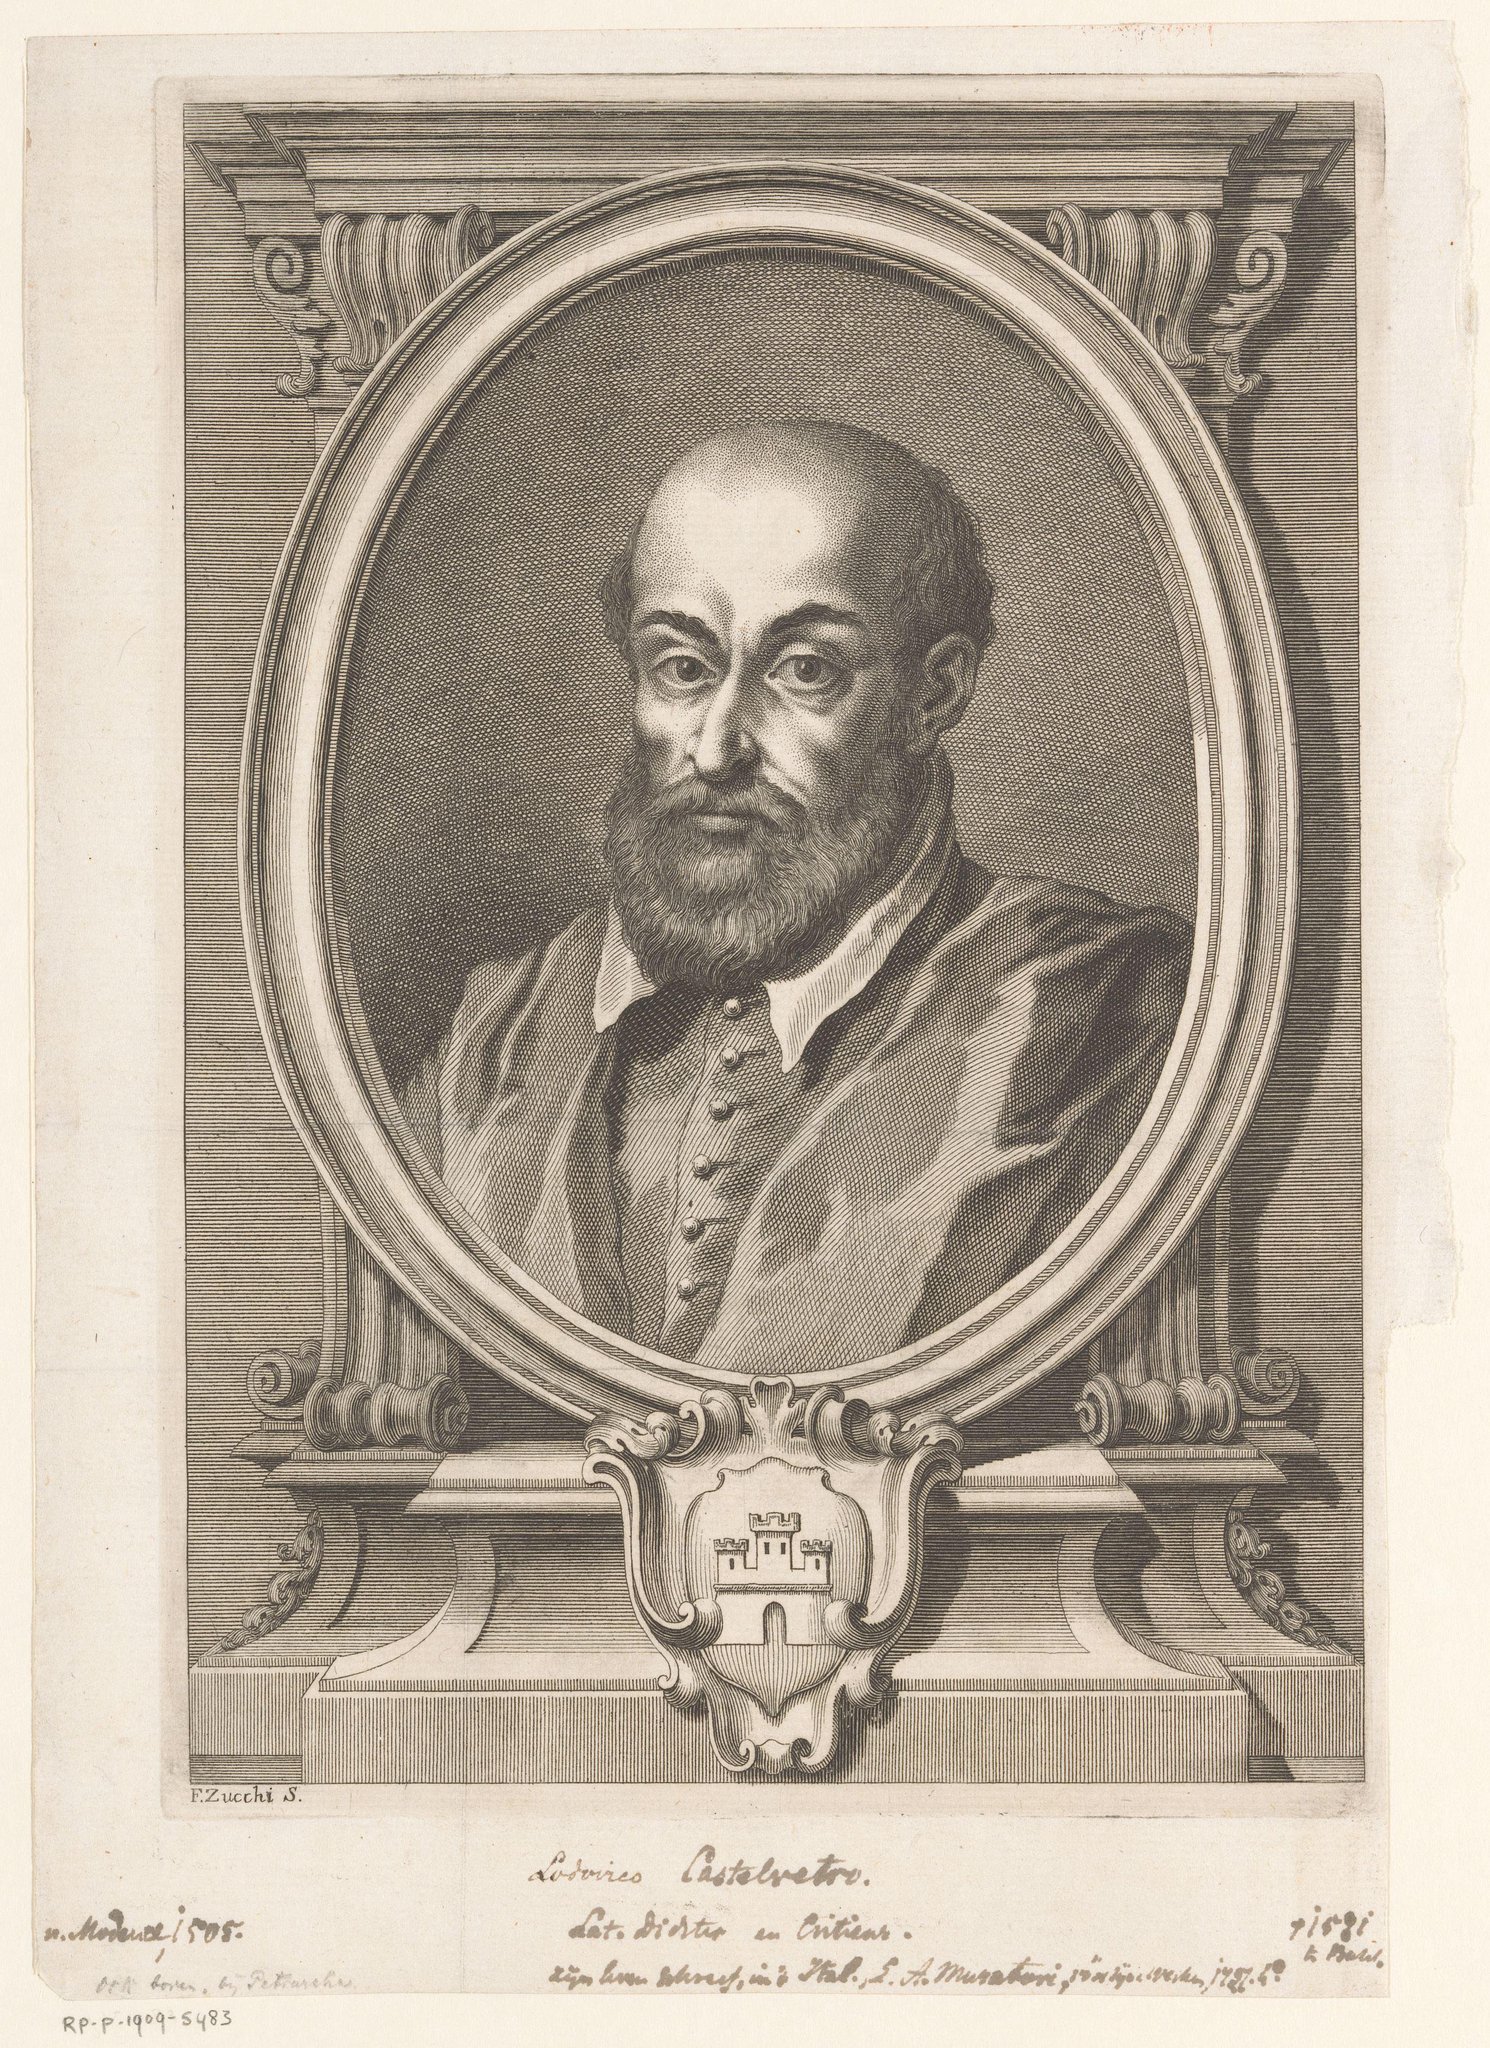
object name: print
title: Portret van filoloog Ludovico Castelvetro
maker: francesco zucchi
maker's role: print maker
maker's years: 1692-1764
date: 1702-1764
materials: paper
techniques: engraving, etching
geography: italy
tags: historical persons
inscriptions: collector's mark: Lugt 2228, inscription: ‘N. Modena 1505 Lodovico Castelvetro Lat. [...] zijn leven [...] 1581 te [...]’